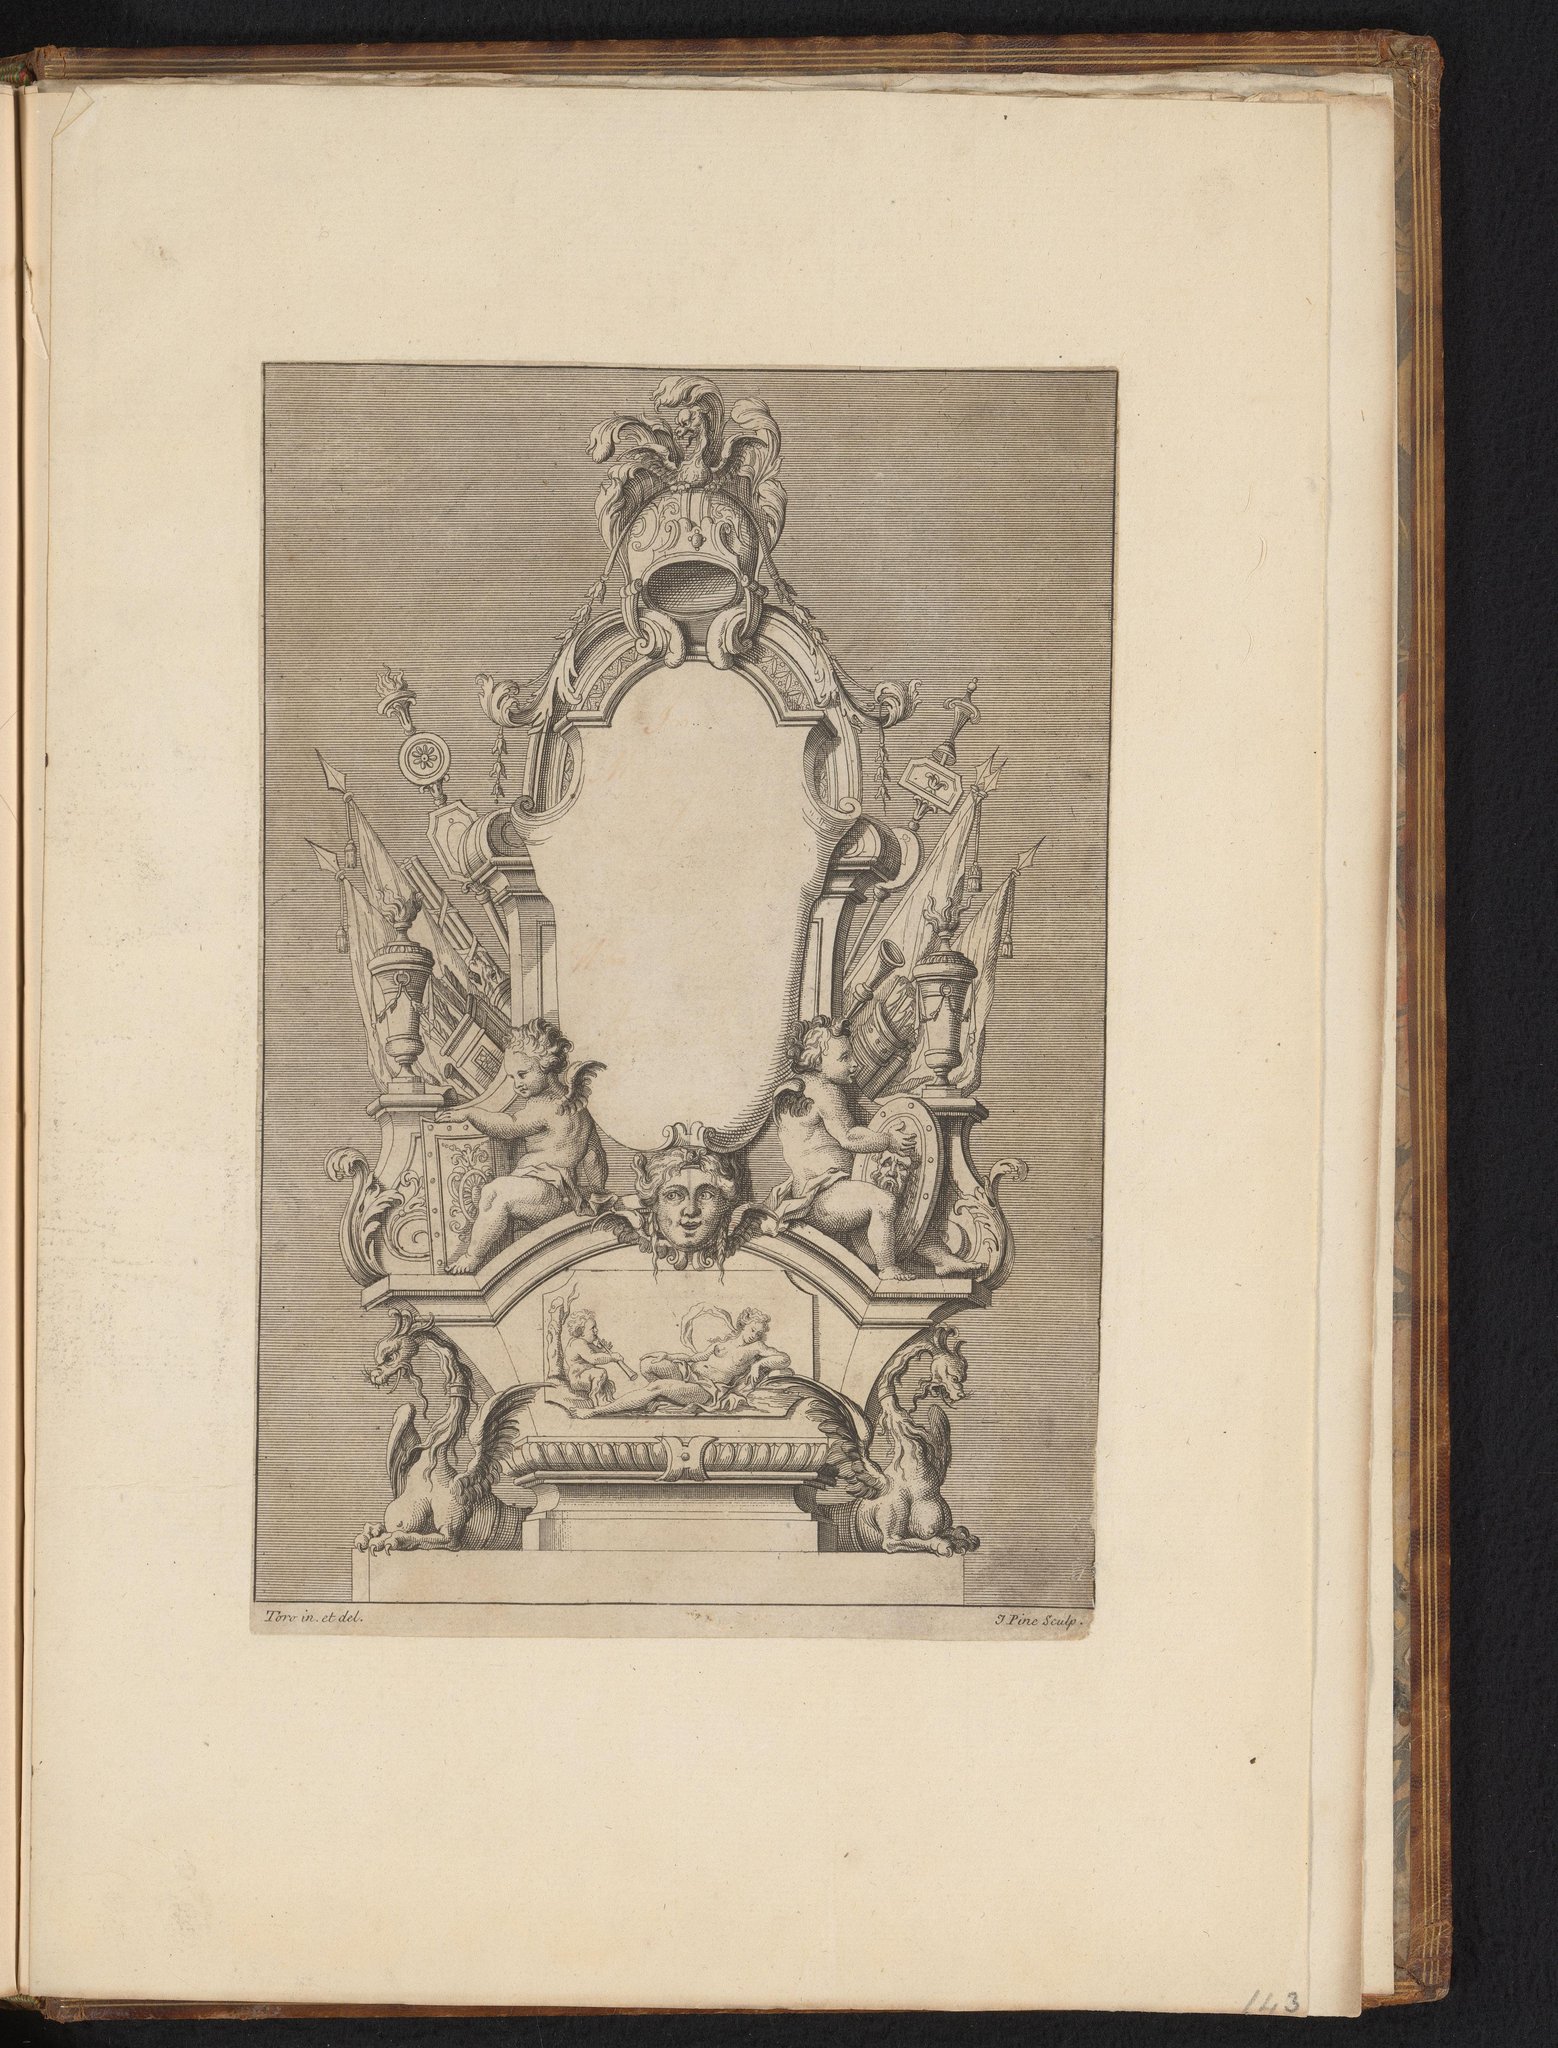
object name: ornament print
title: Ornamenten voor kunstenaars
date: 1716-1730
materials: paper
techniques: etching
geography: london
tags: 'tropaion', i.e. decorative ornament ~ weapons, ornament ~ cartouche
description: Titelprent voor een verder onbekende serie. Het betreft een Londense uitgave met prenten naar ontwerp van Turreau.